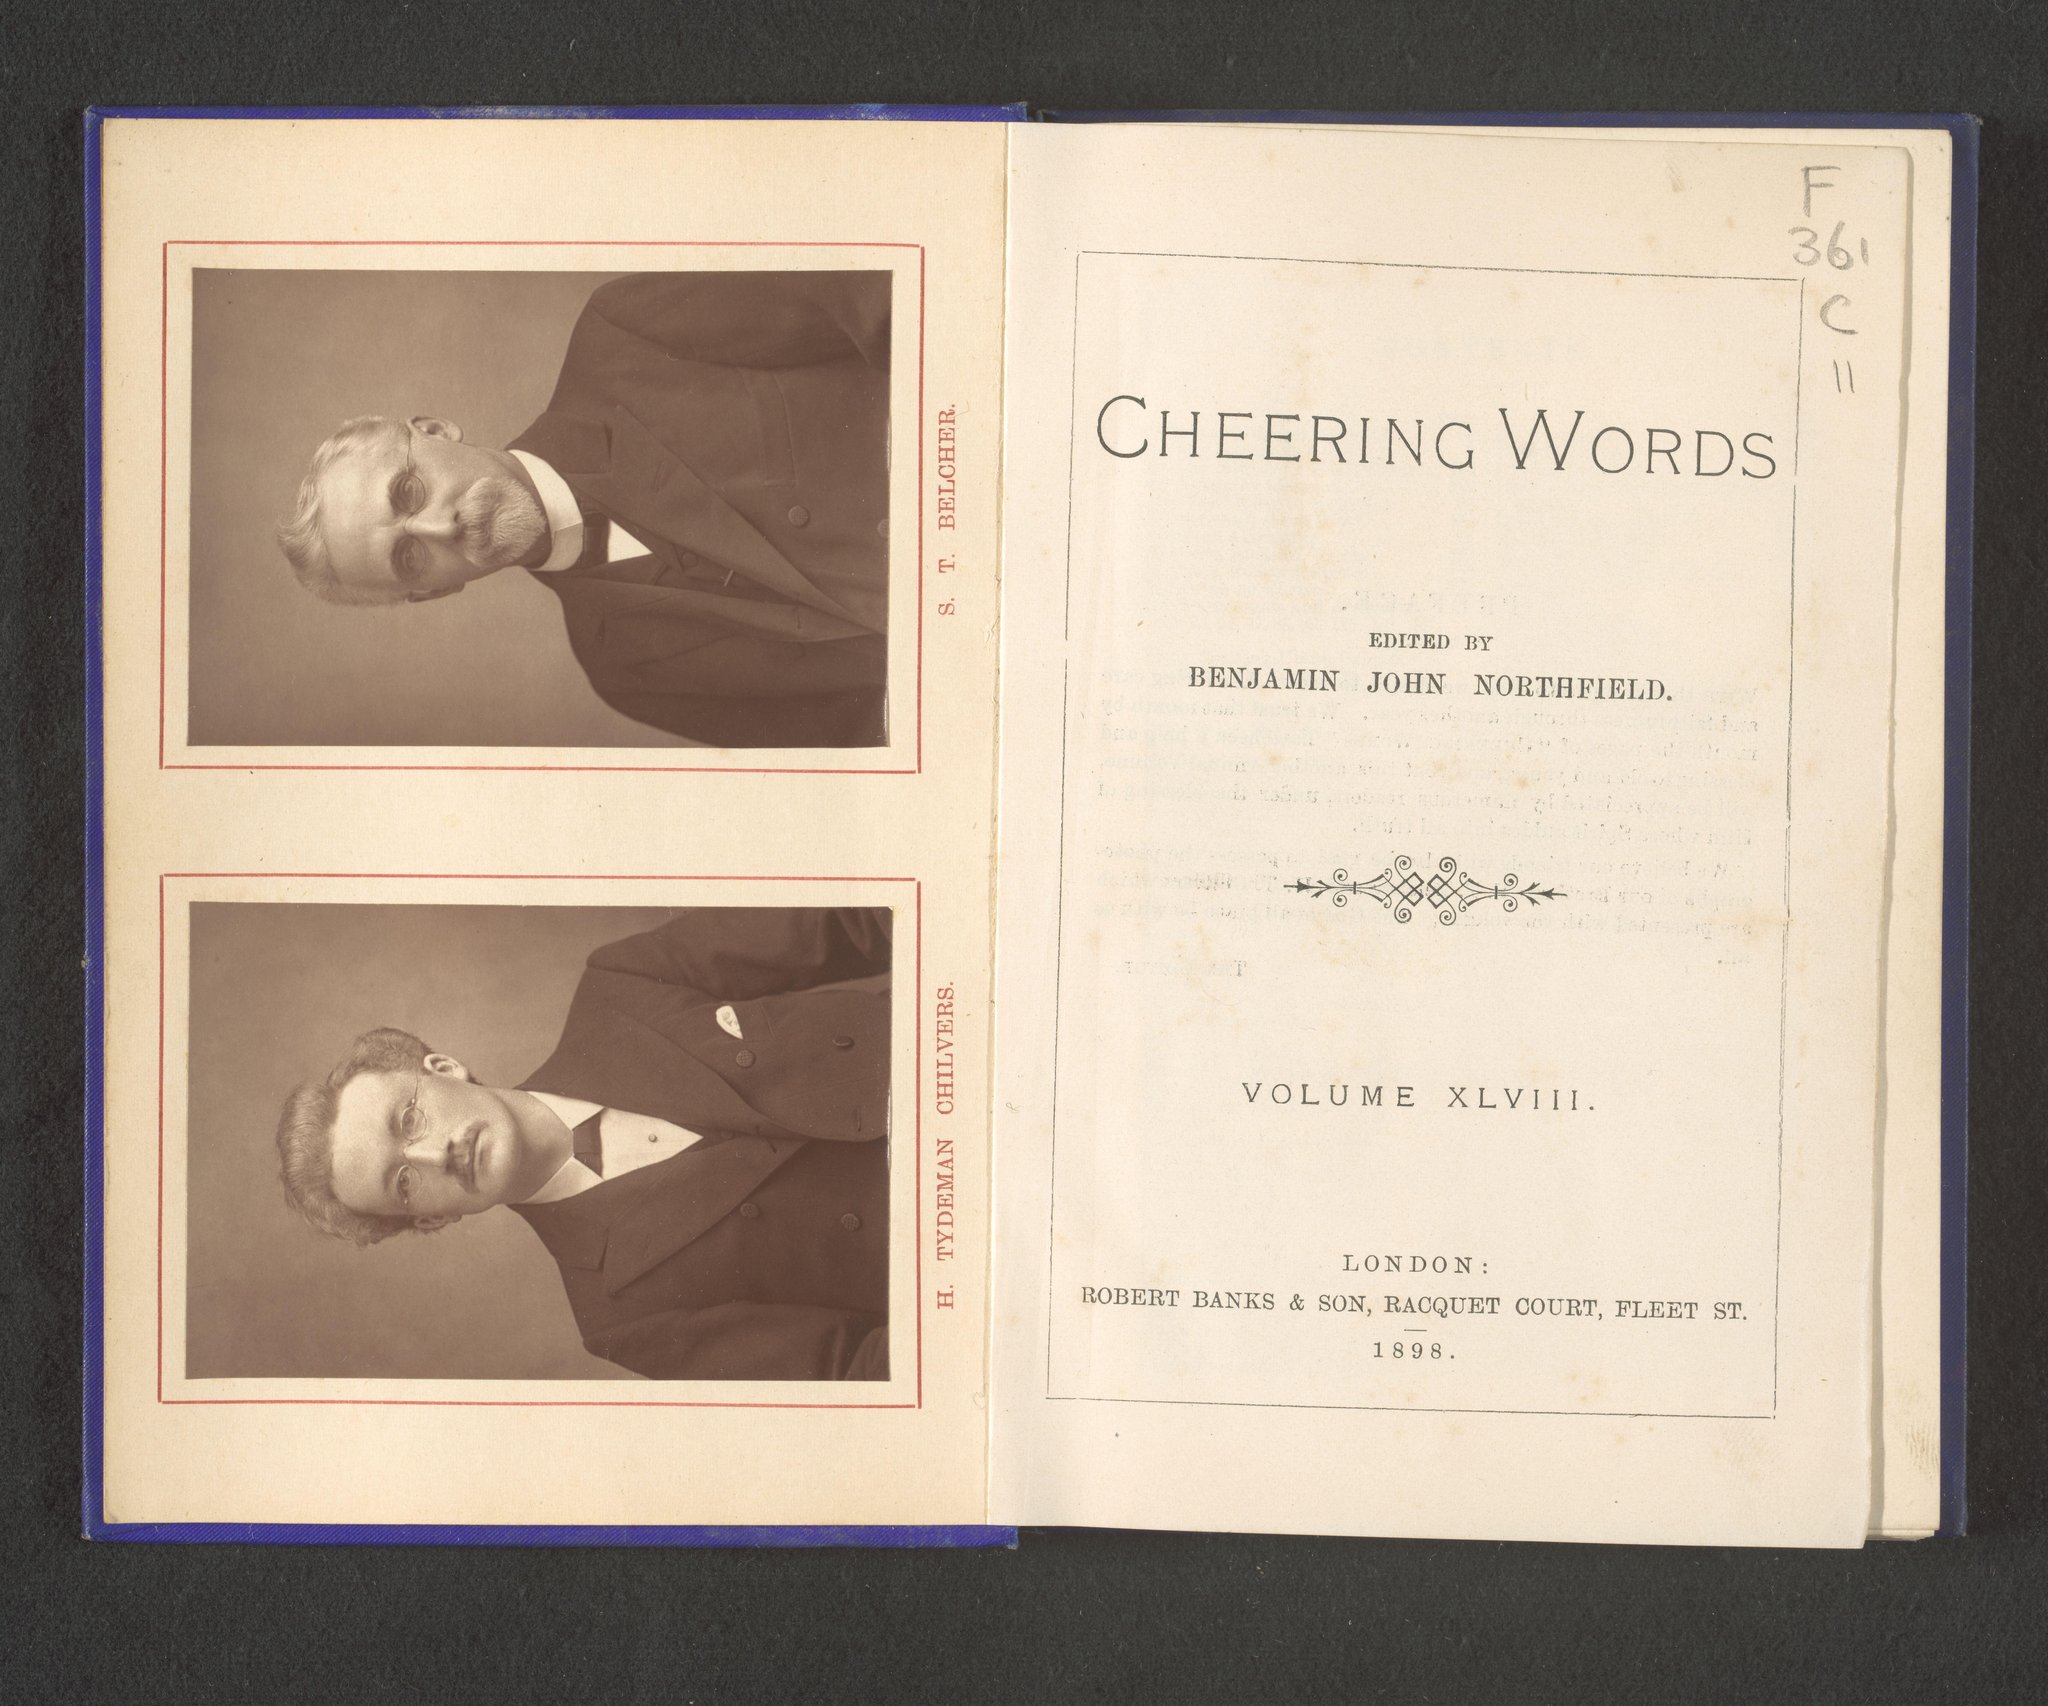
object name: page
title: Portret van H. Tydeman Chilvers en S. T. Belcher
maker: Anonymous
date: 1893-1898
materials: paper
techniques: woodburytype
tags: adult man, historical persons